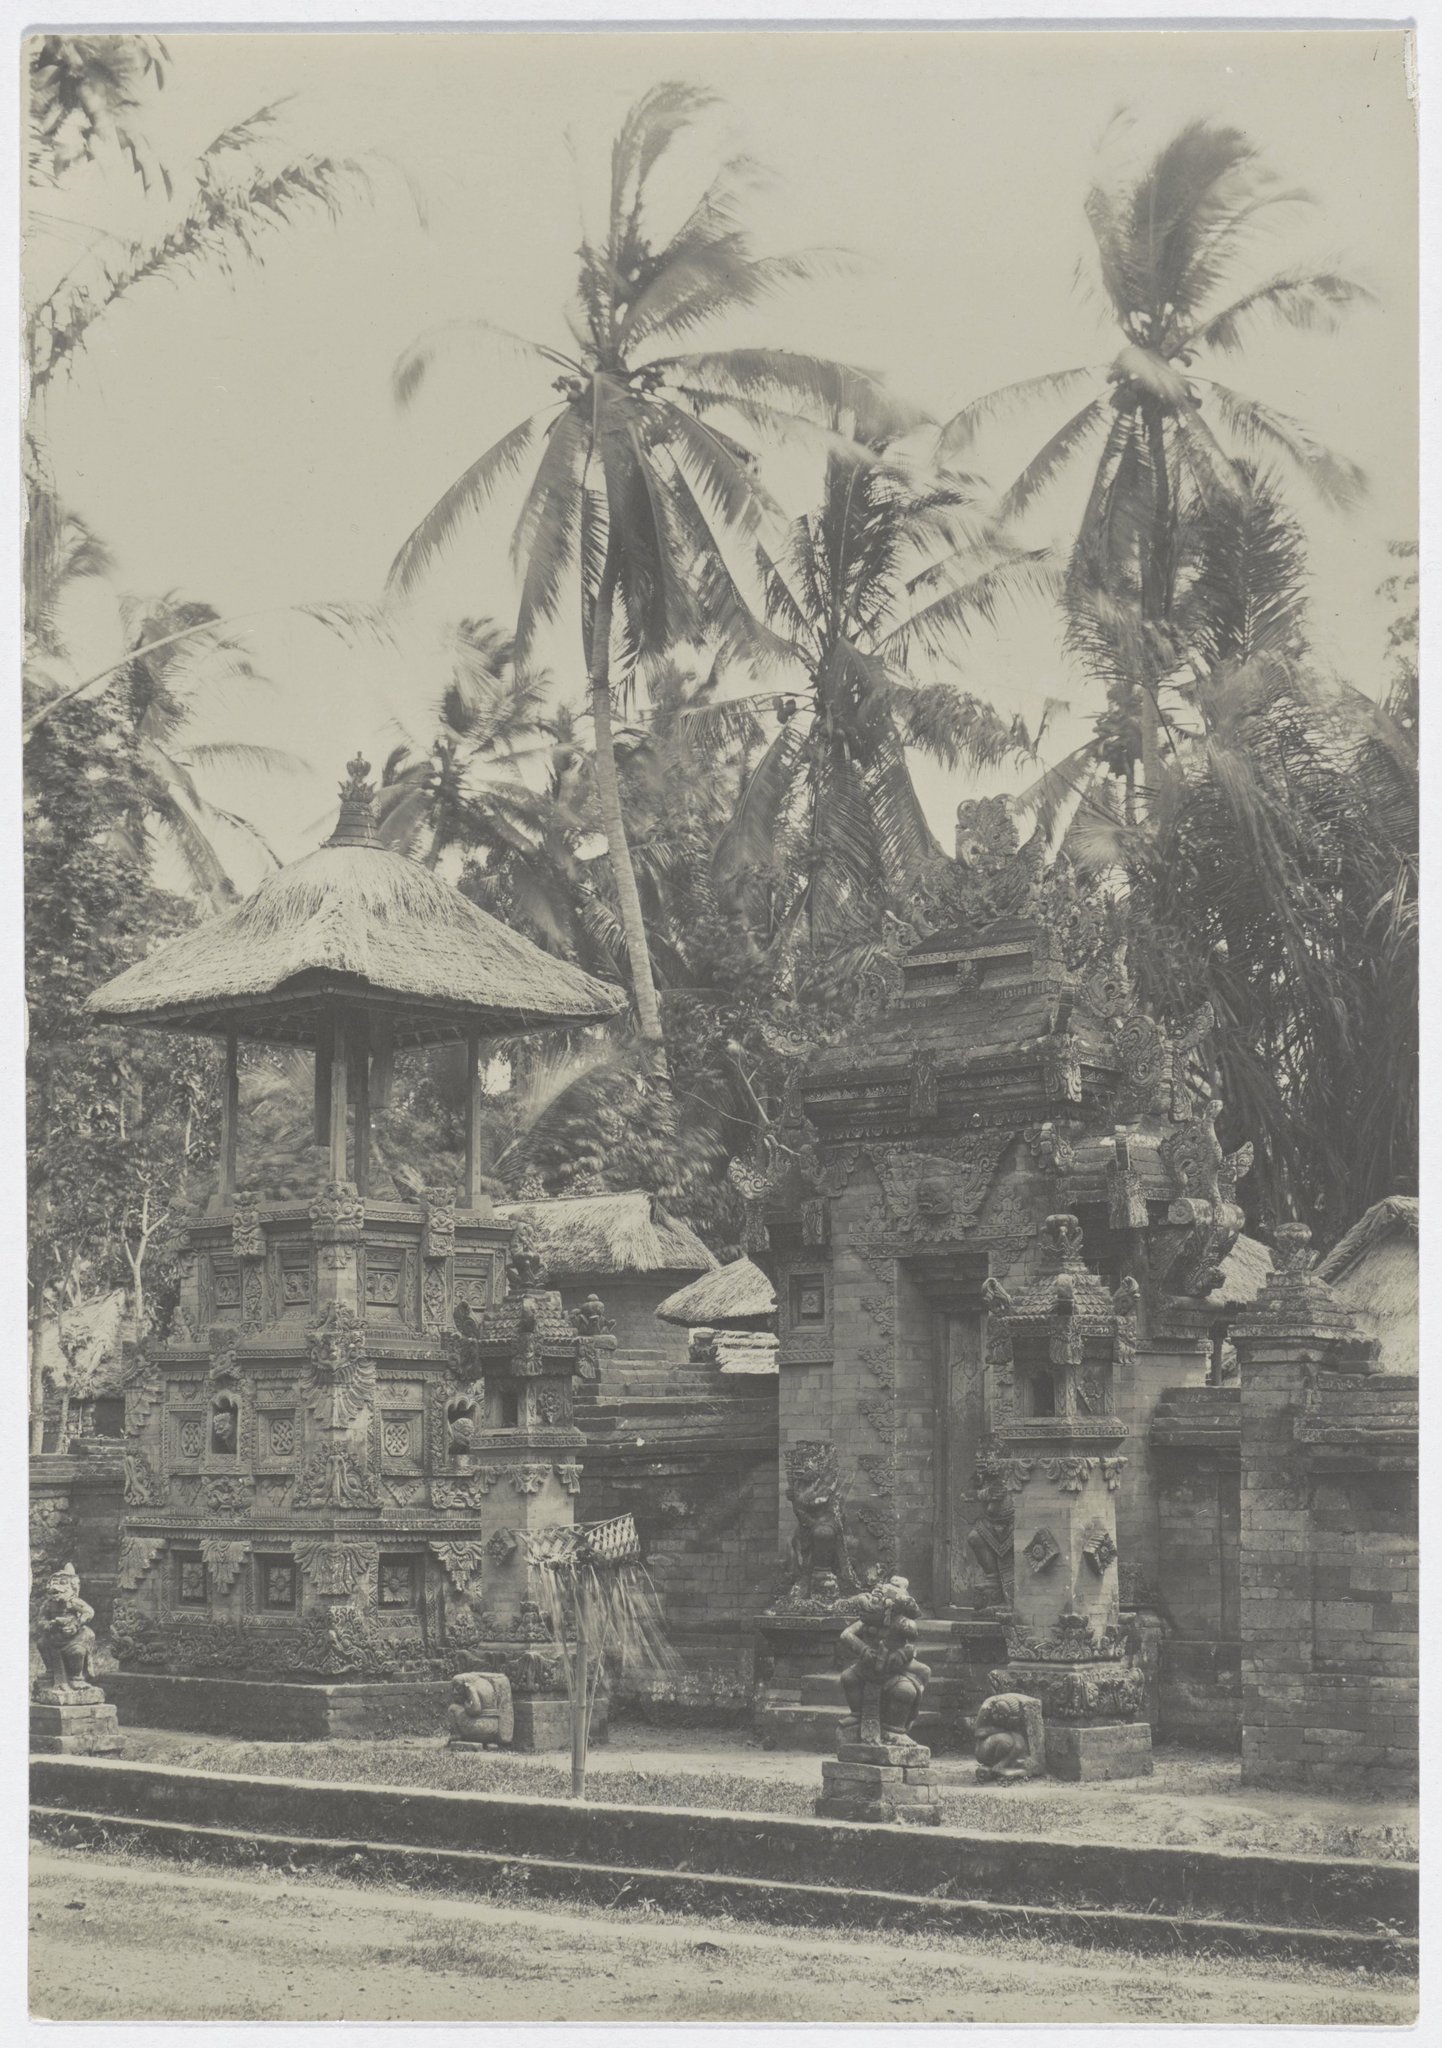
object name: photograph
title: Een gedecoreerde poort met daarvoor een kleine tempel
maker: johanna hermina marmelstein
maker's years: 1897-1990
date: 1900-1915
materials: paper, photographic support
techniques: albumen print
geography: jakarta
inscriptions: inscription: ‘Ingang van een aanzienlijk huis. Tempeltje, logis voor de huisgoden, stenen deurwachters.’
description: Aan weerszijden van de poort staan stenen poortwachters.